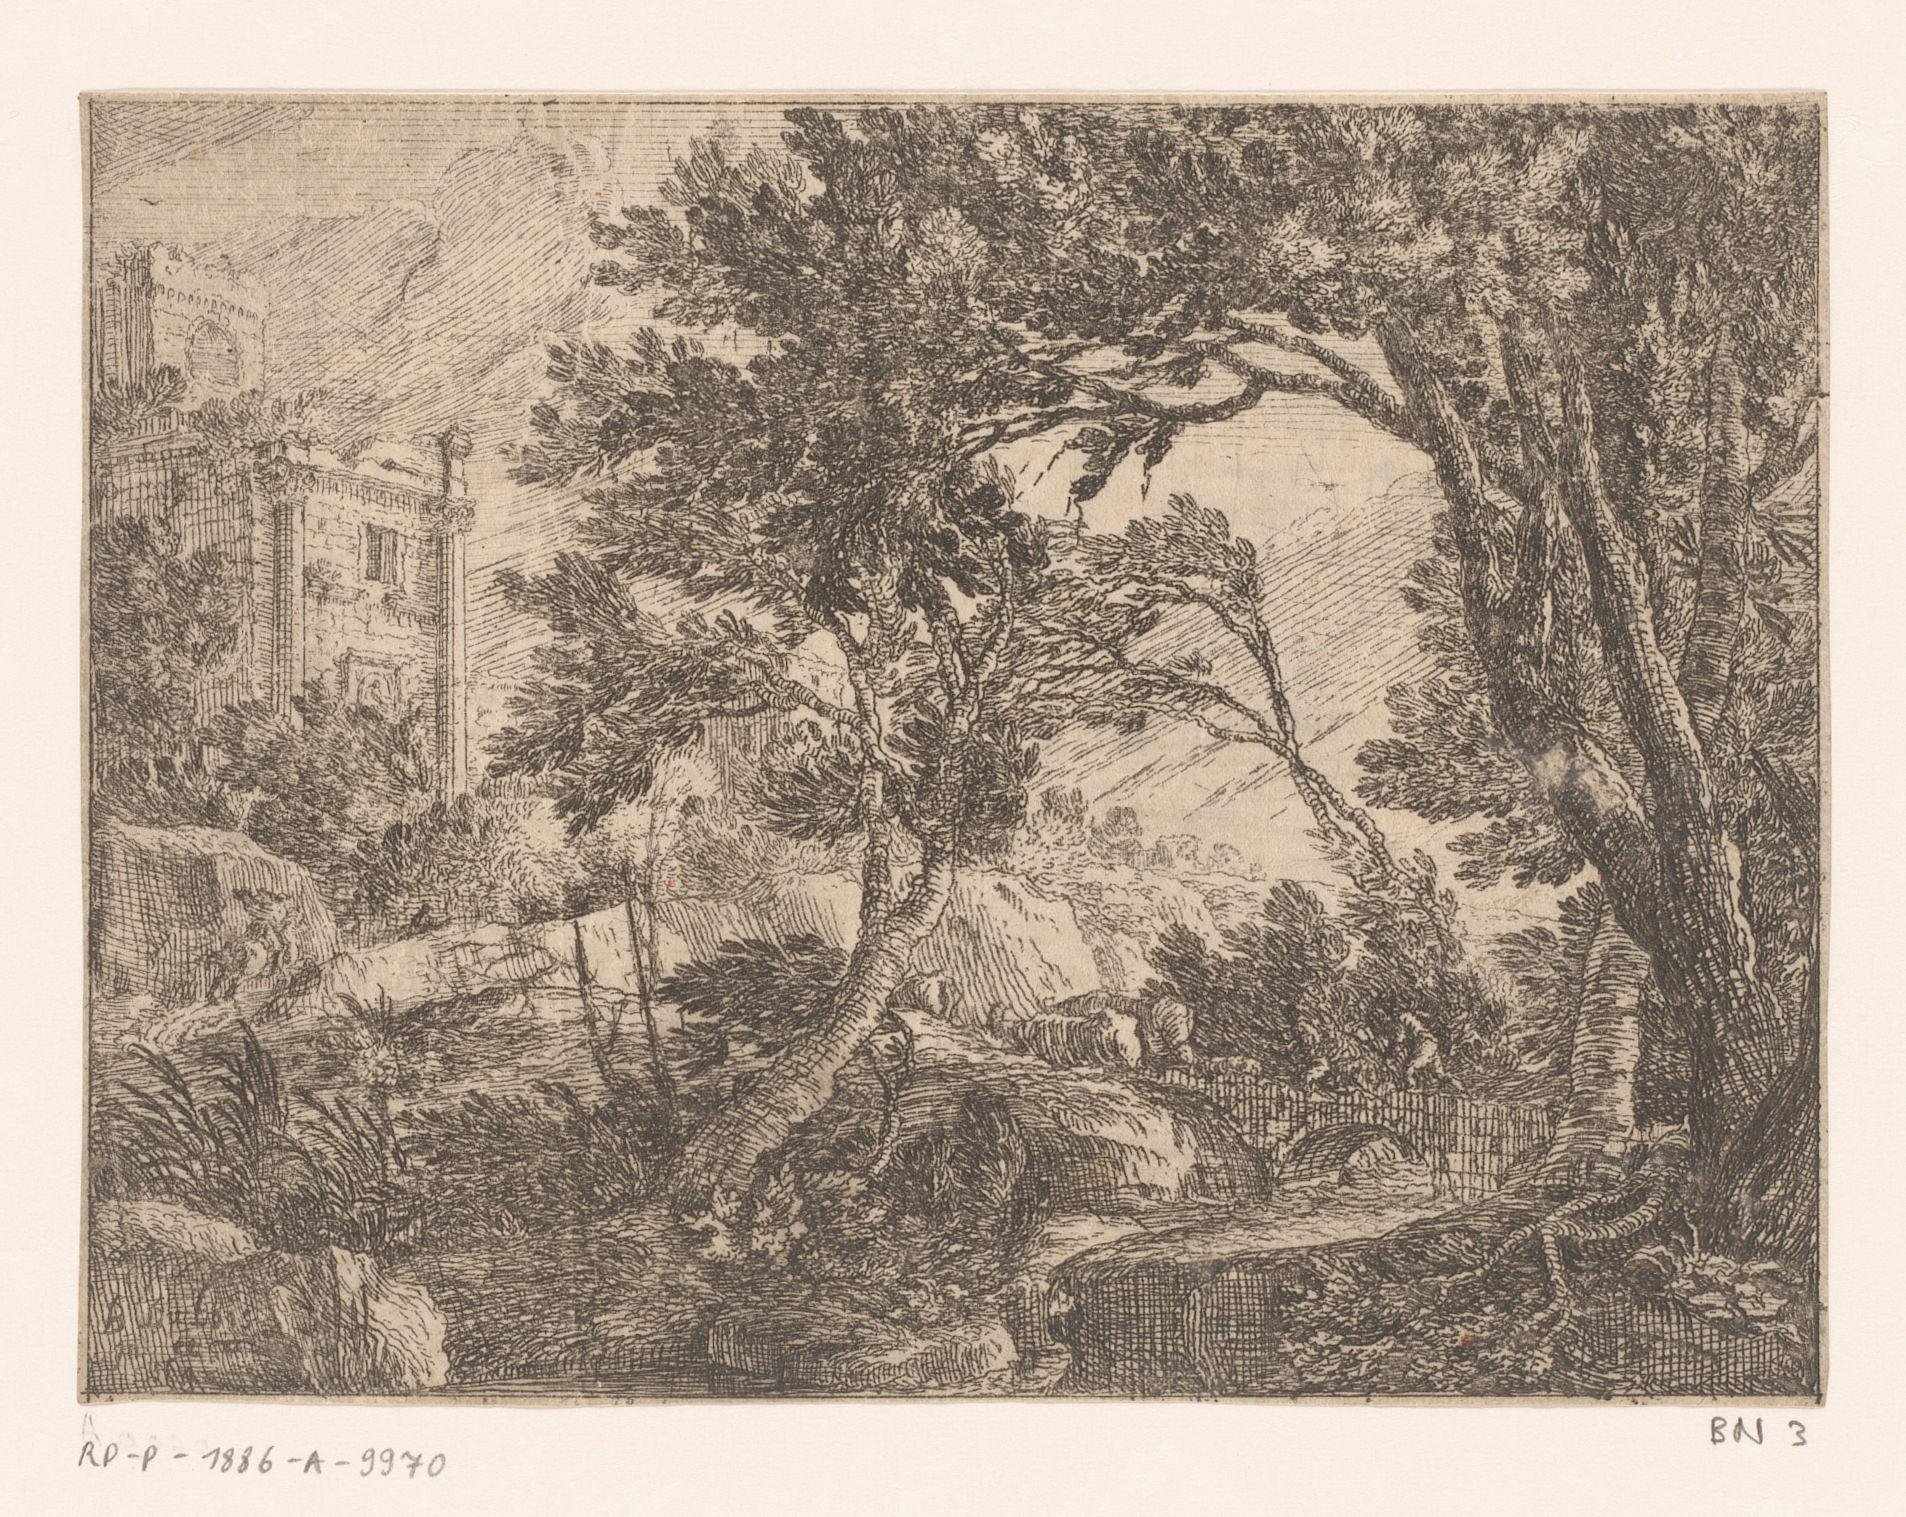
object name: print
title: Landschap met villa in een storm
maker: benoît dubois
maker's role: print maker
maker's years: 1619-1680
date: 1629-1680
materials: paper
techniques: drypoint, etching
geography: france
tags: landscapes, villa, storm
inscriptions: collector's mark: Lugt 2228